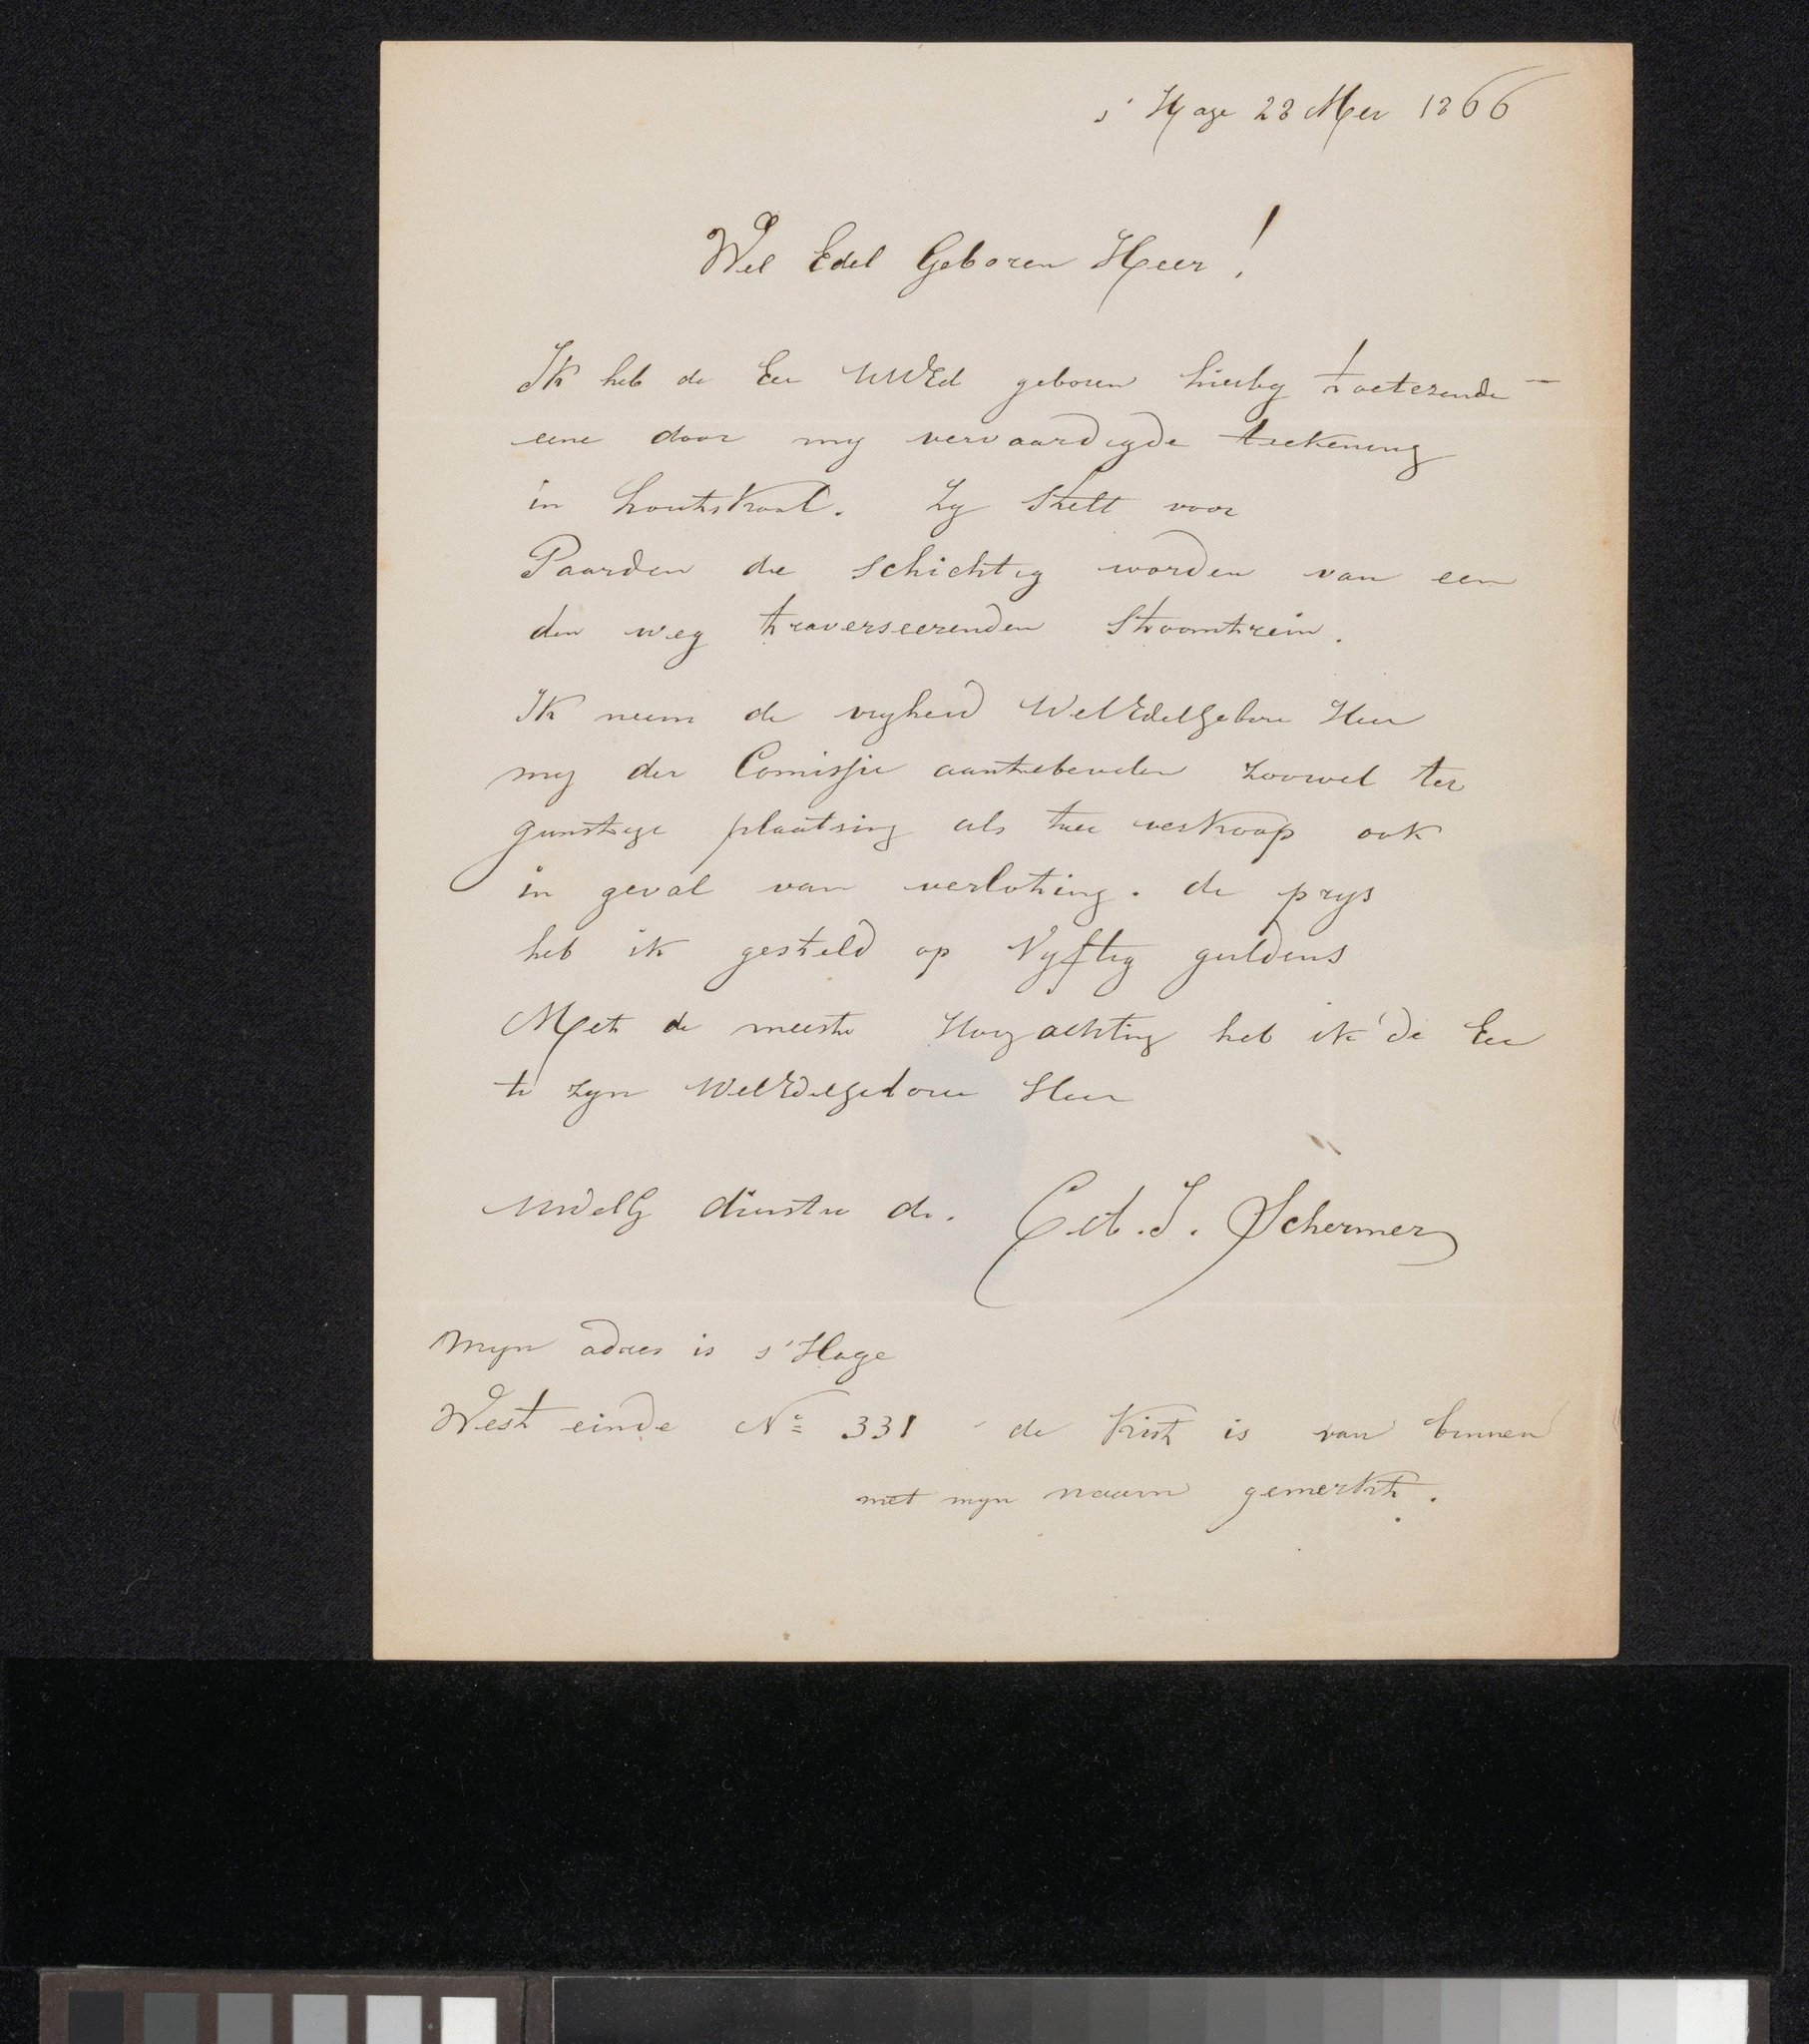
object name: letter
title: Brief aan Pieter Verloren van Themaat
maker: cornelis albertus johannes schermer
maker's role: draughtsman, painter, print maker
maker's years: 1824-1915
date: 1866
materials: ink, paper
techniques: pen, writing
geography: the hague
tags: utrecht, pieter verloren van themaat, drawing, exhibition ~ art, money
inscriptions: collector's mark: ‘RPK’